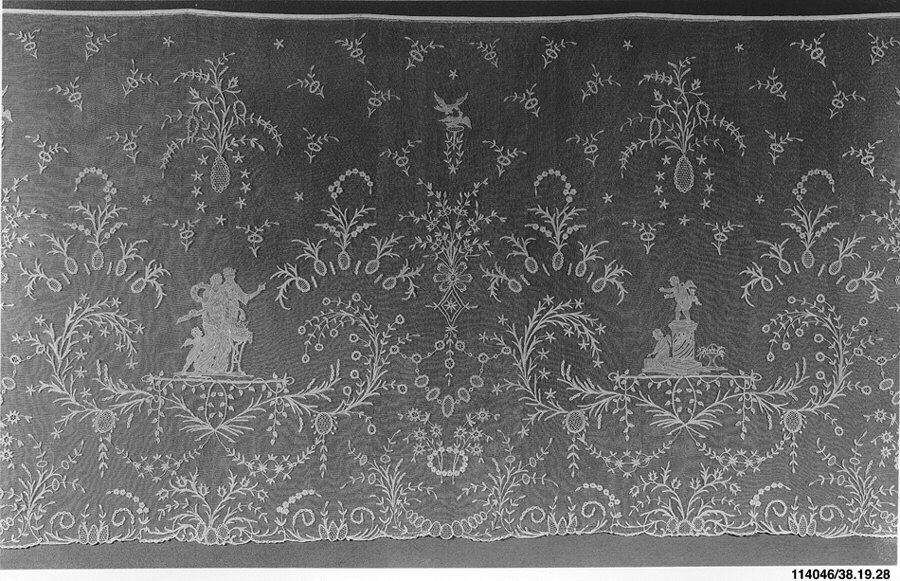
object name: flounce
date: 1767-1800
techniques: lace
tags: human figures